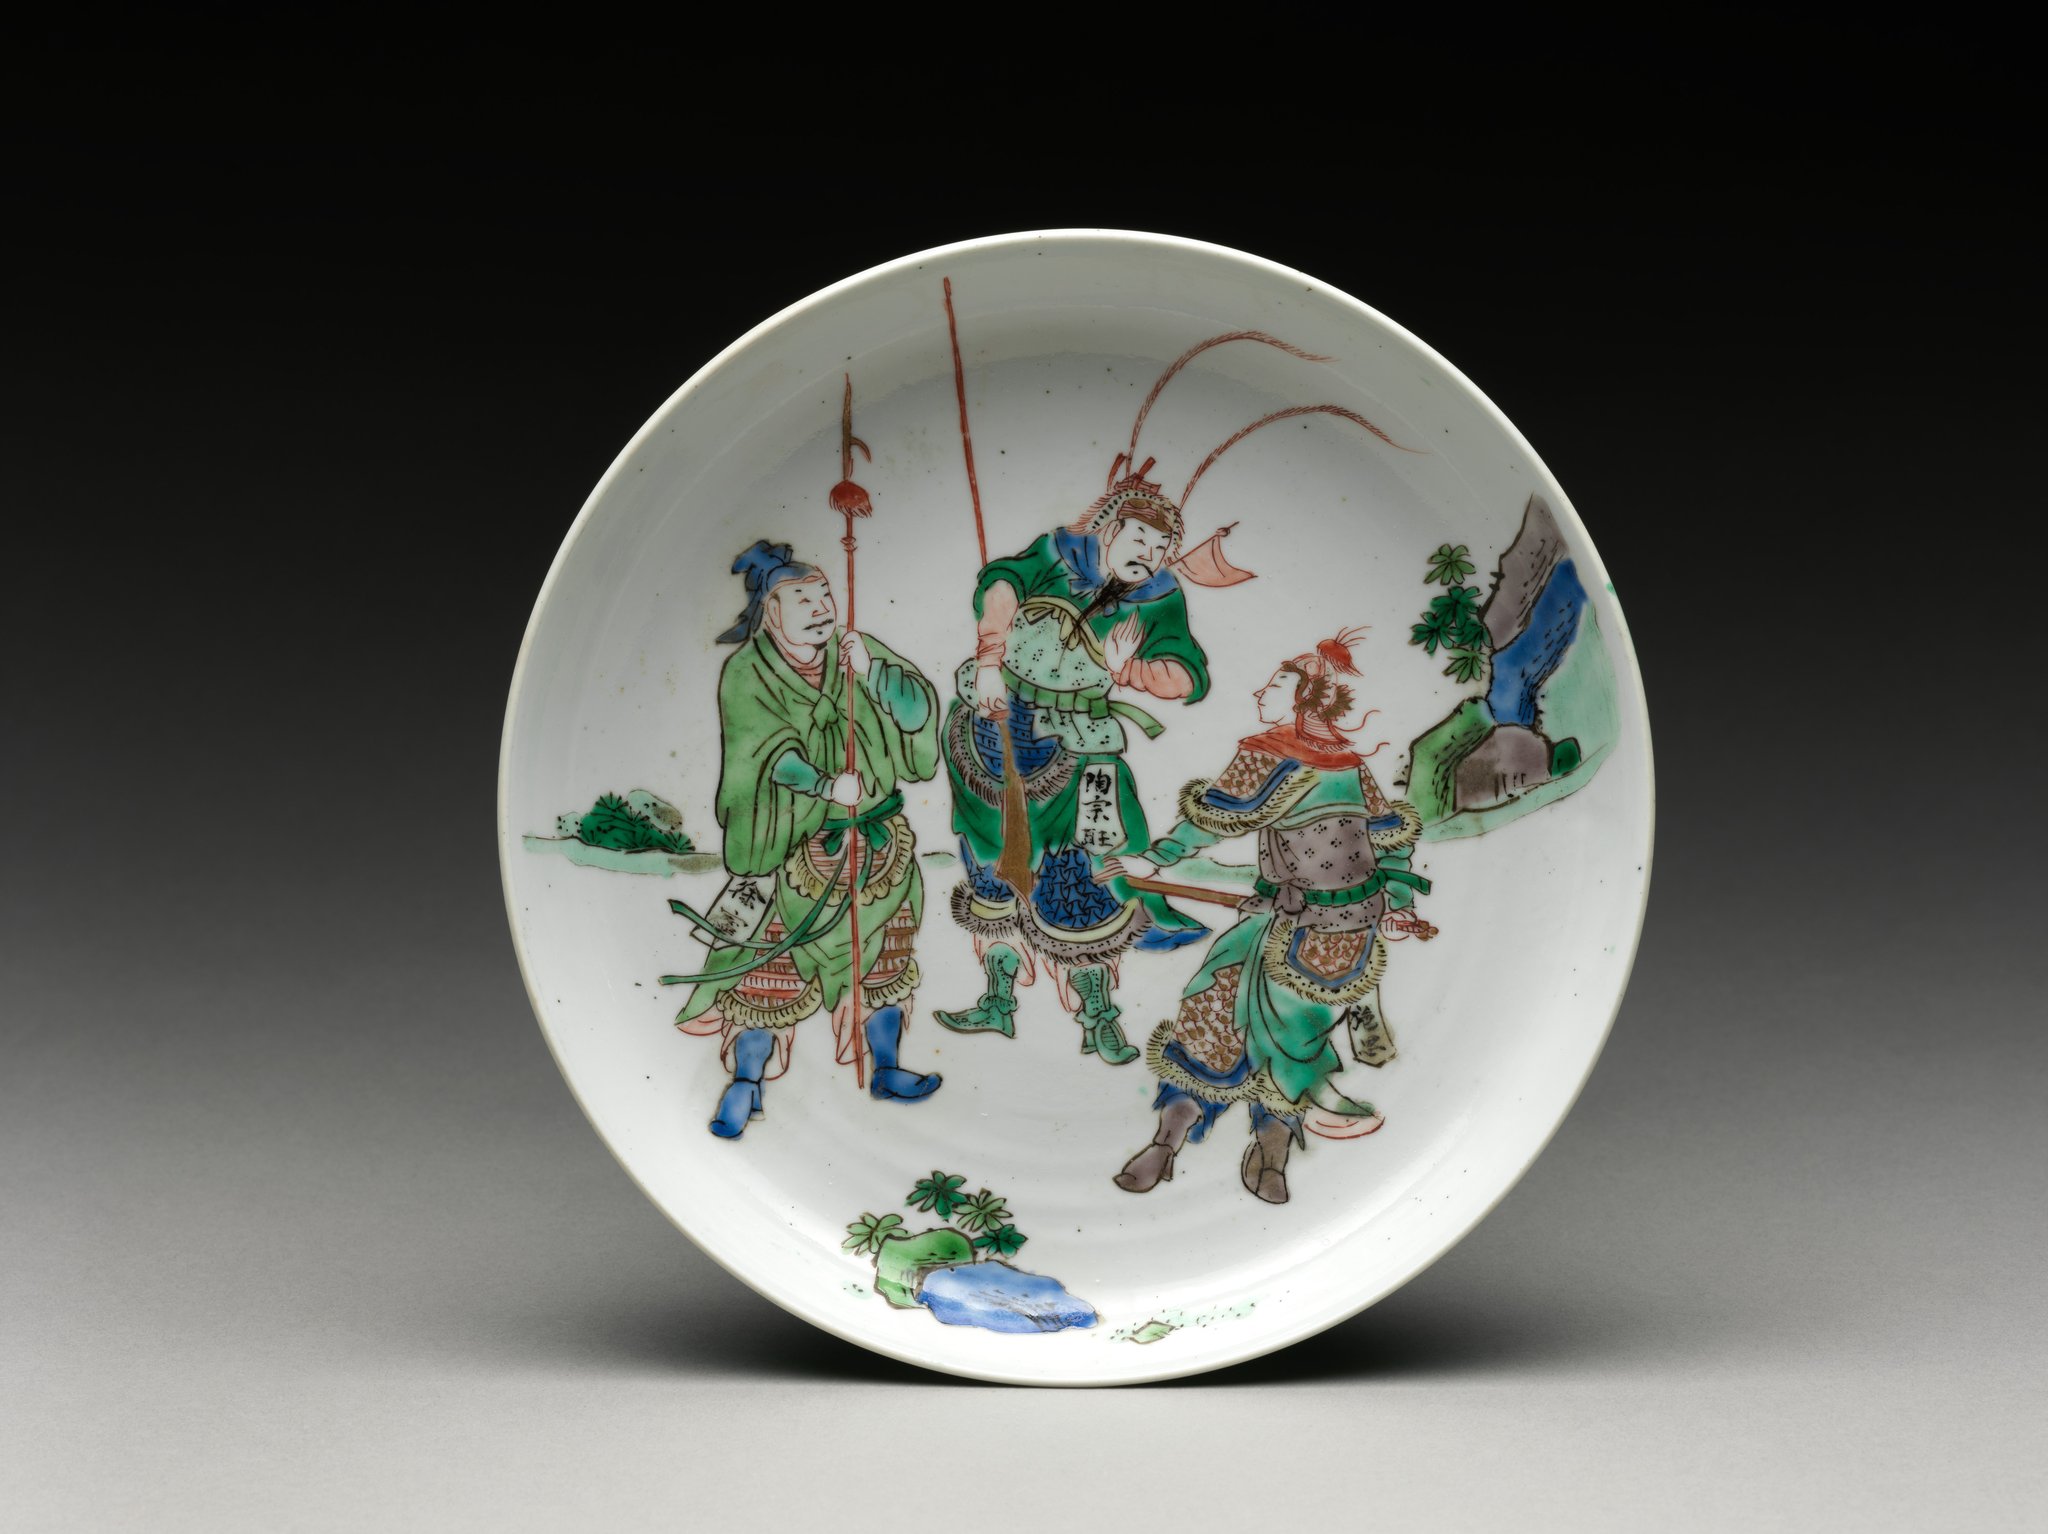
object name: dish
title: Dish with three heroes from Water Margin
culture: chinese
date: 1662-1722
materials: enamel, porcelain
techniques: overglaze, painting, polychrome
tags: men